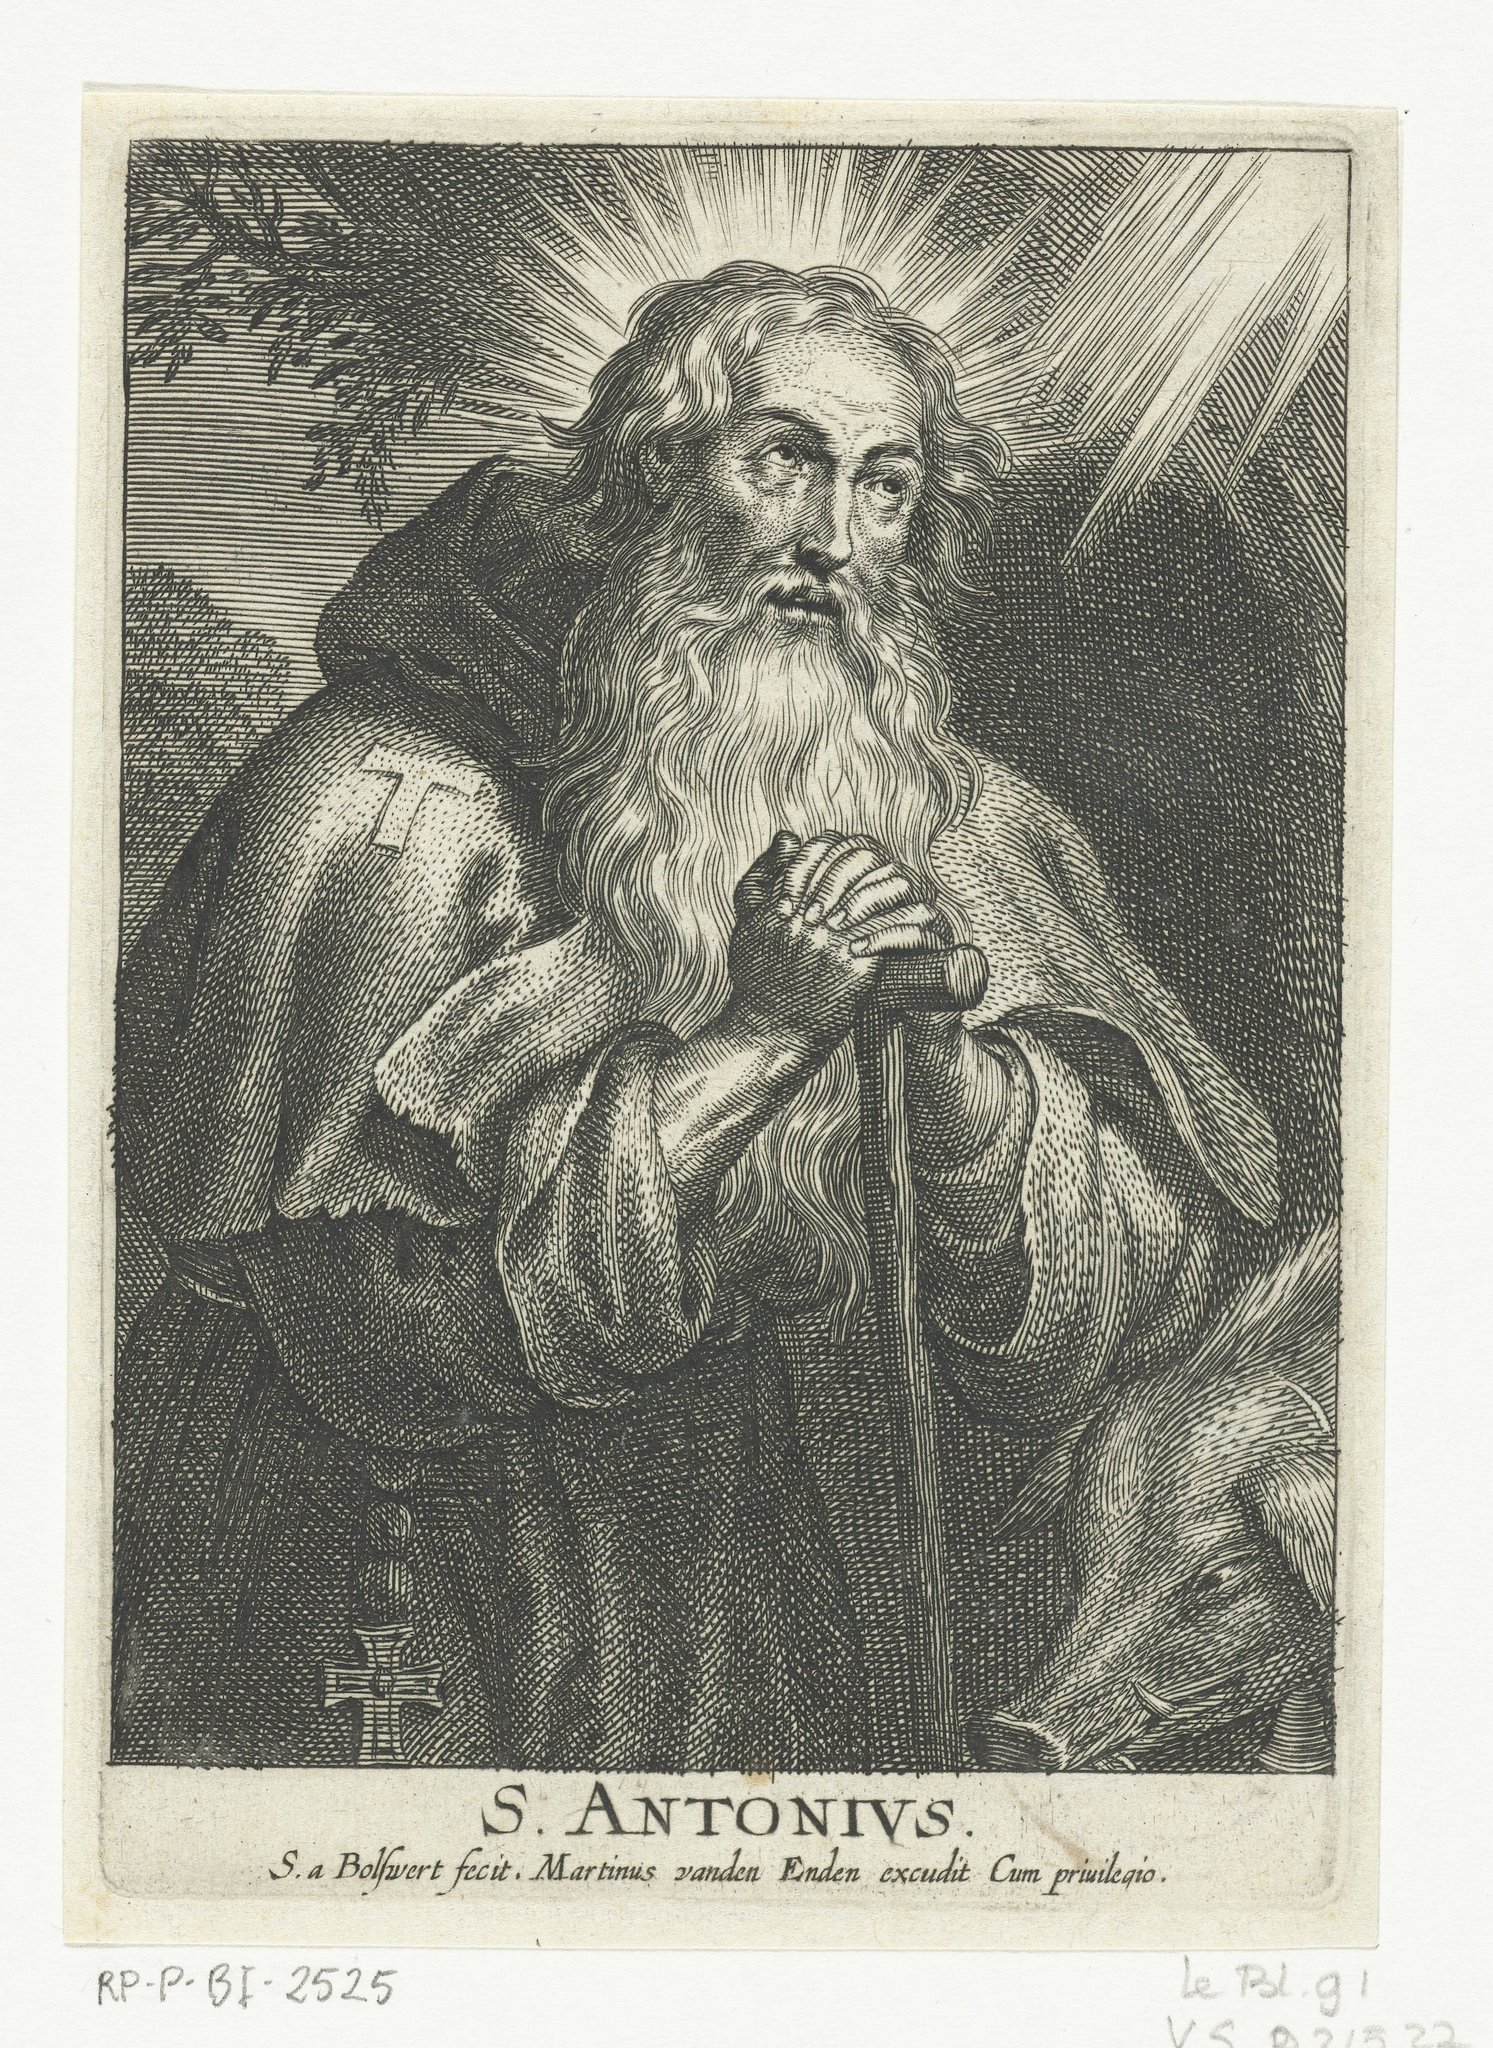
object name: print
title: S. Antonivs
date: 1596-1659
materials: paper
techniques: engraving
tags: the hermit antony abbot (antonius abbas) of egypt, also called the great; possible attributes: bell, book, t-shaped staff, flames, pig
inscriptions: : Lugt 240, collector's mark: Lugt 2228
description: Prent naar ontwerp van Peter Paul Rubens.